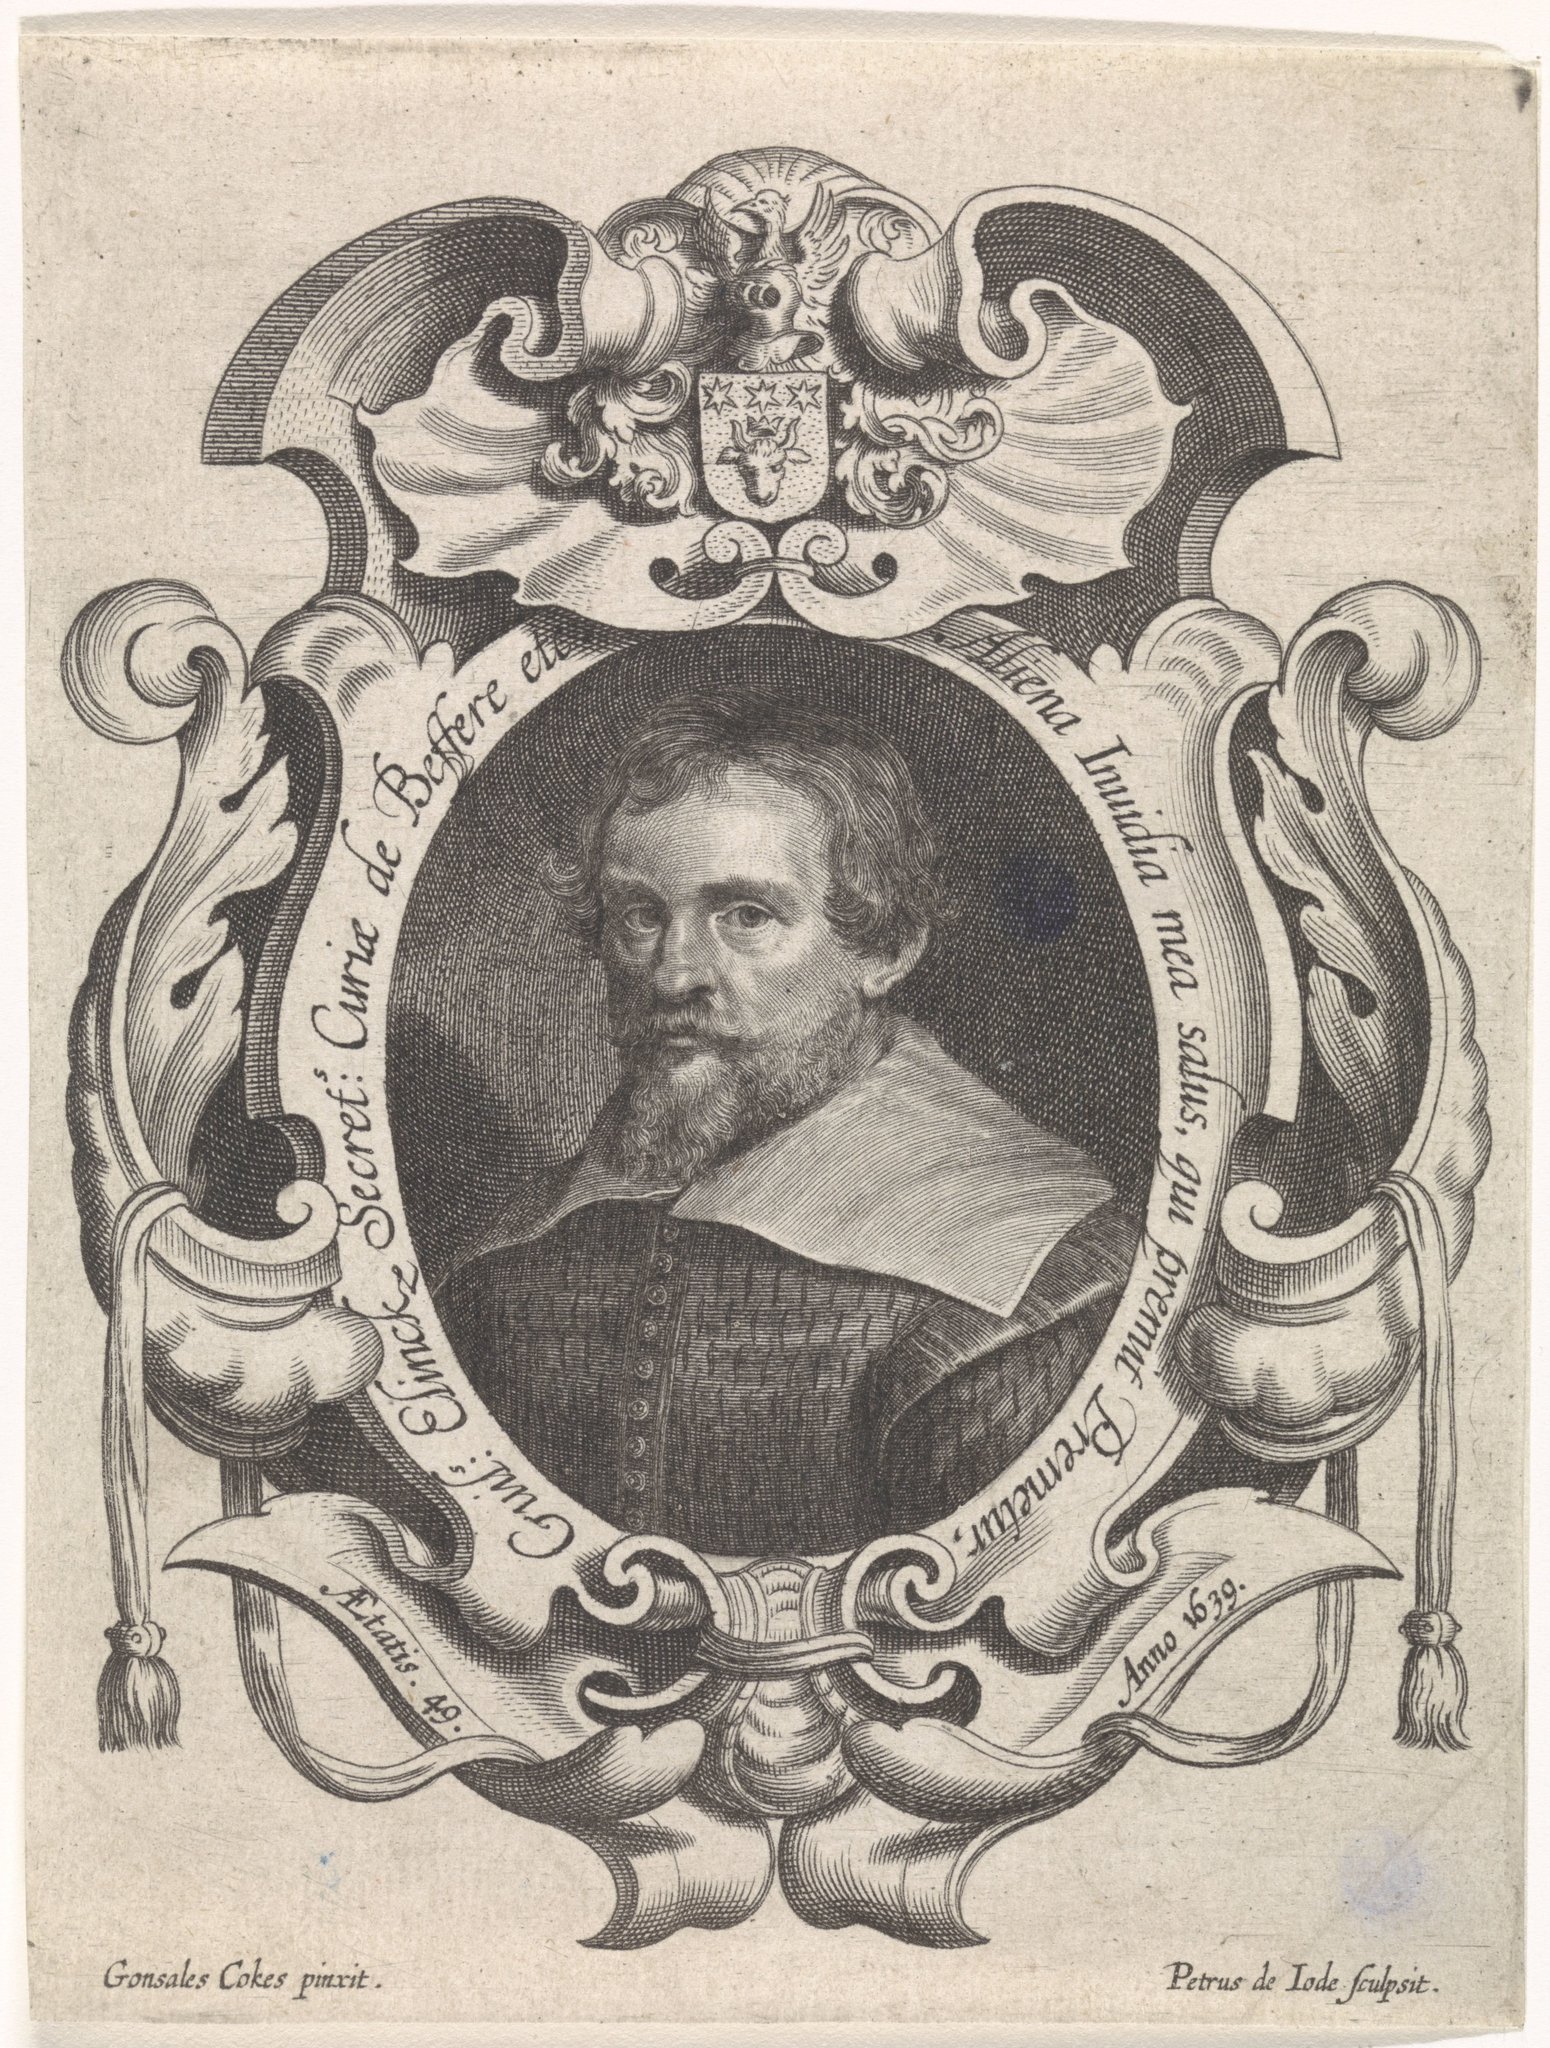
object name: print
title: Portret van Willem Elinck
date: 1639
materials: paper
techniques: engraving, etching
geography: antwerp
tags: willem elinck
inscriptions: collector's mark: Lugt 2228, collector's mark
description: Busteportret van de secretaris Willem Elinck, op 49-jarige leeftijd. Het portret is gevat in een cartouche met een randschrift in het Latijn en bekroond met zijn wapenschild.